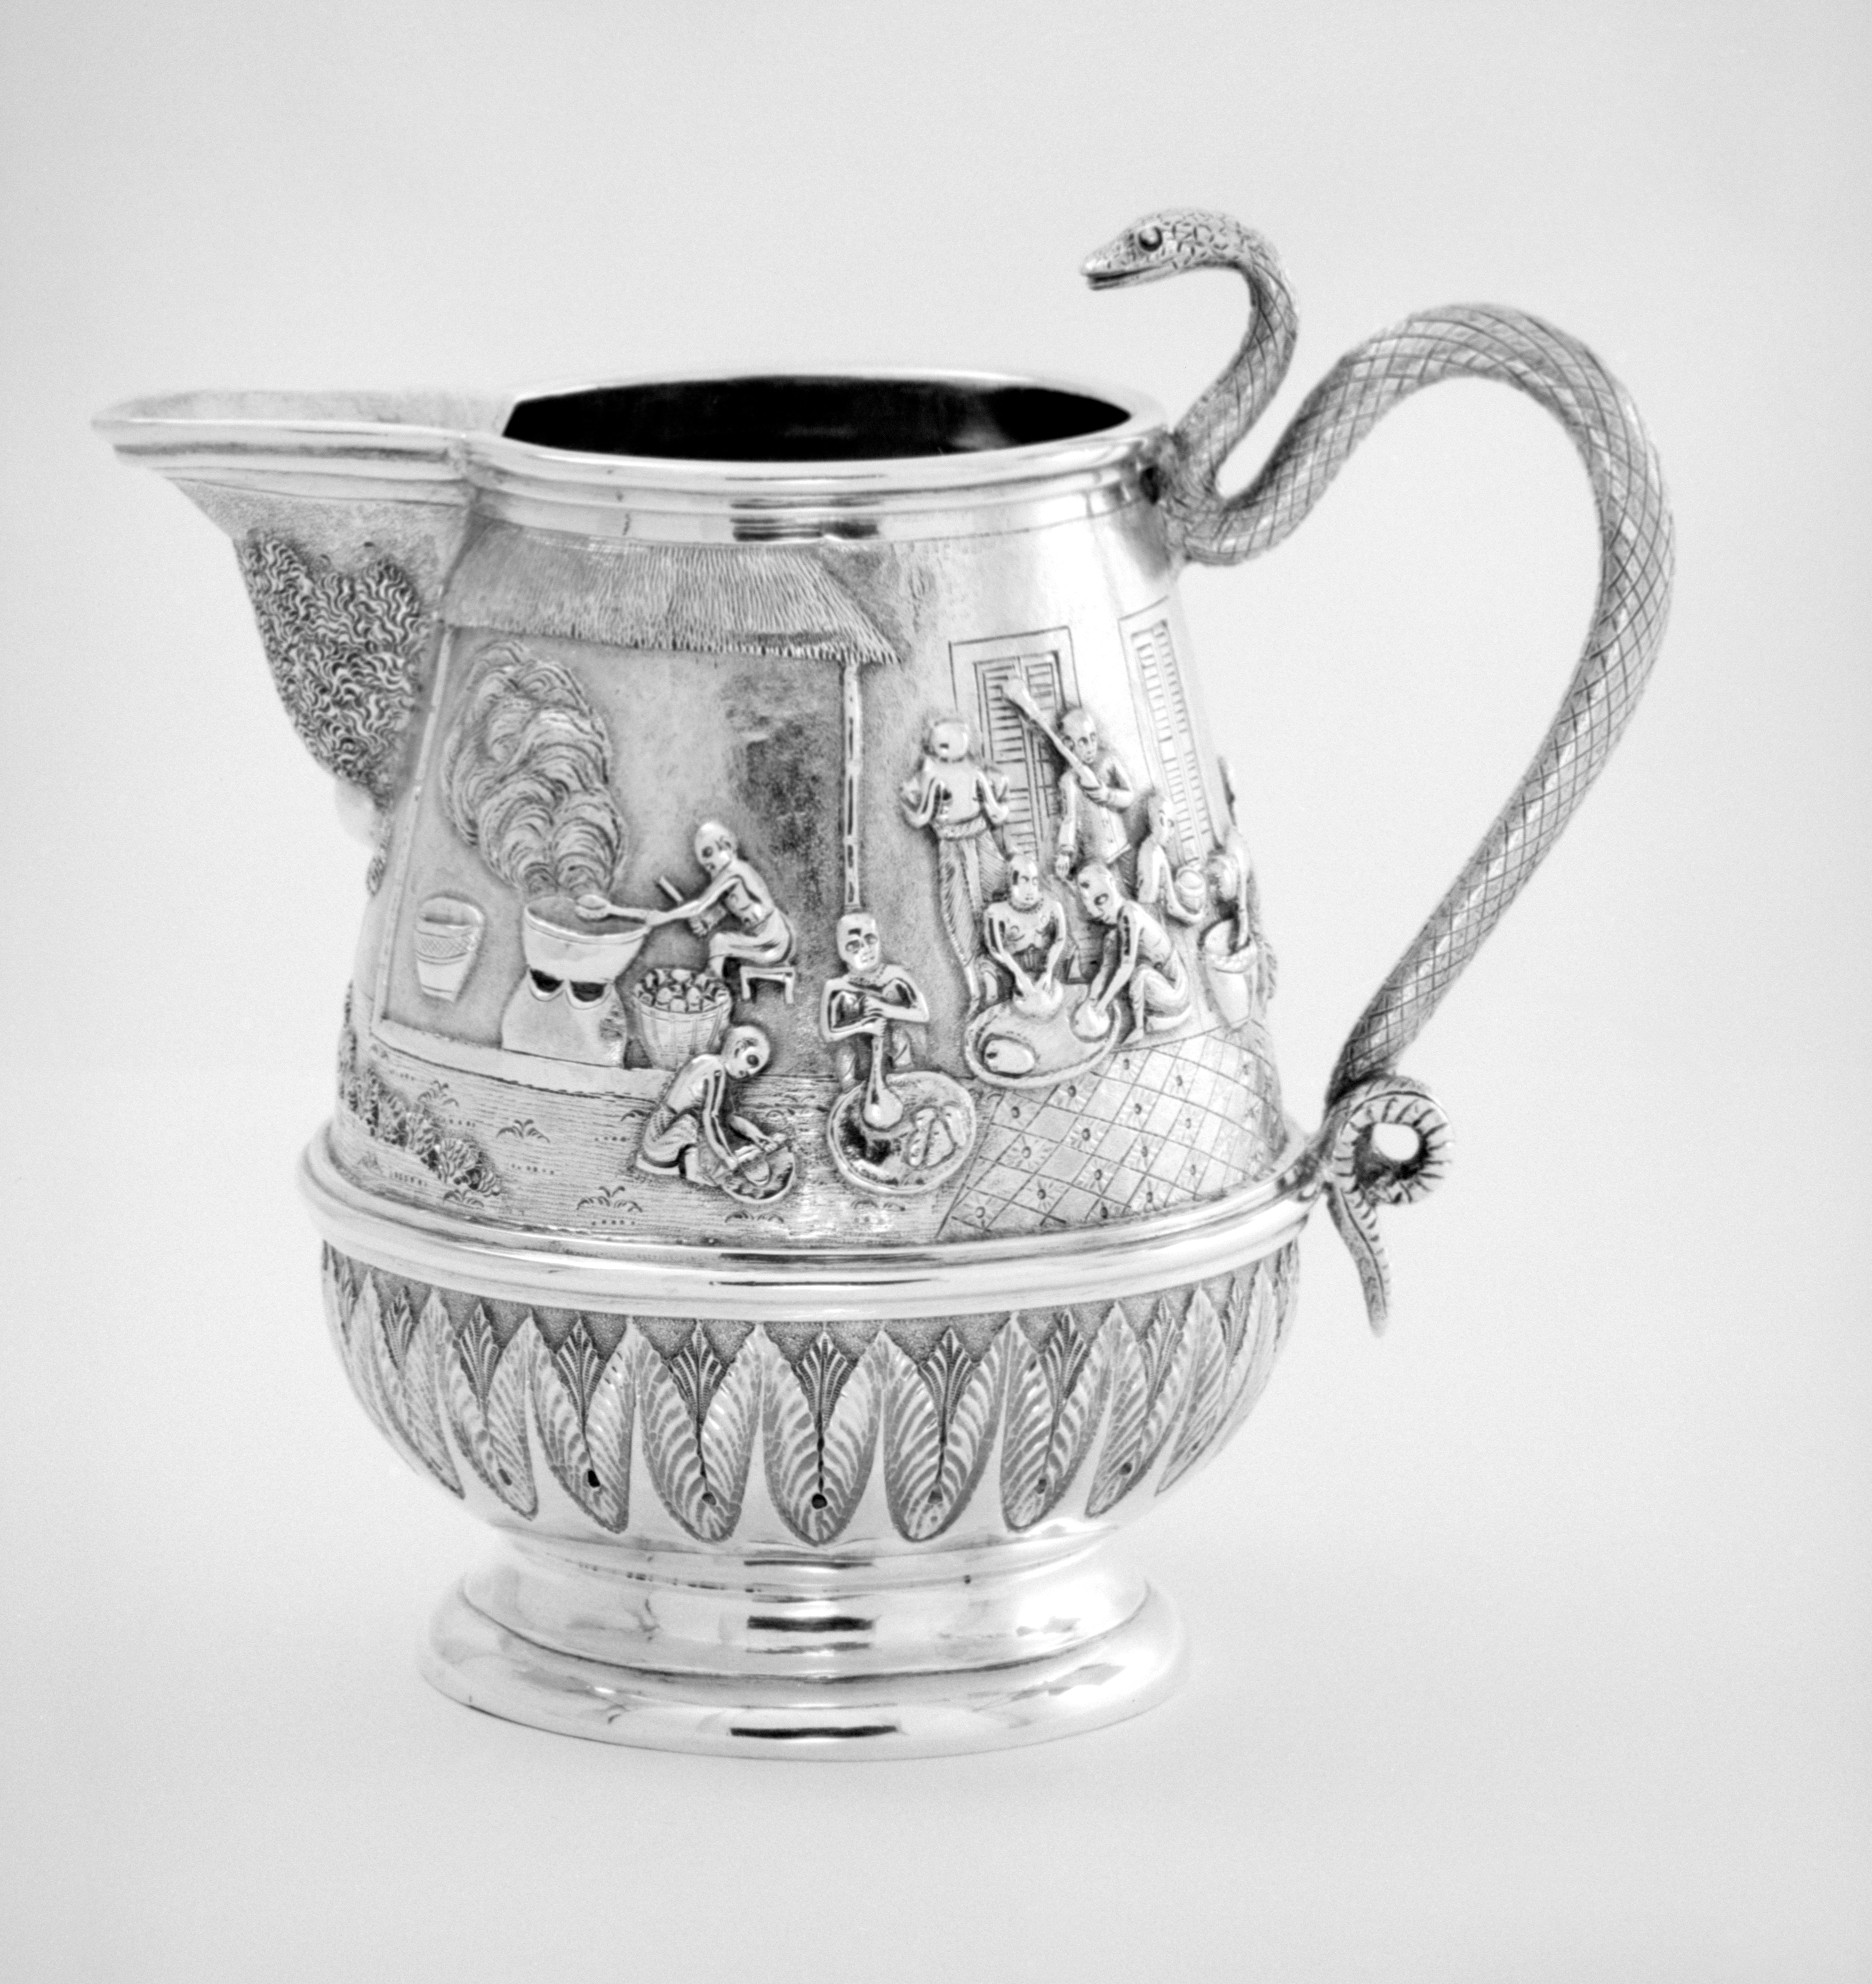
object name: cream pitcher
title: Cream pitcher (part of a set)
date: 1860-1880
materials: silver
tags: food,snakes,cooking